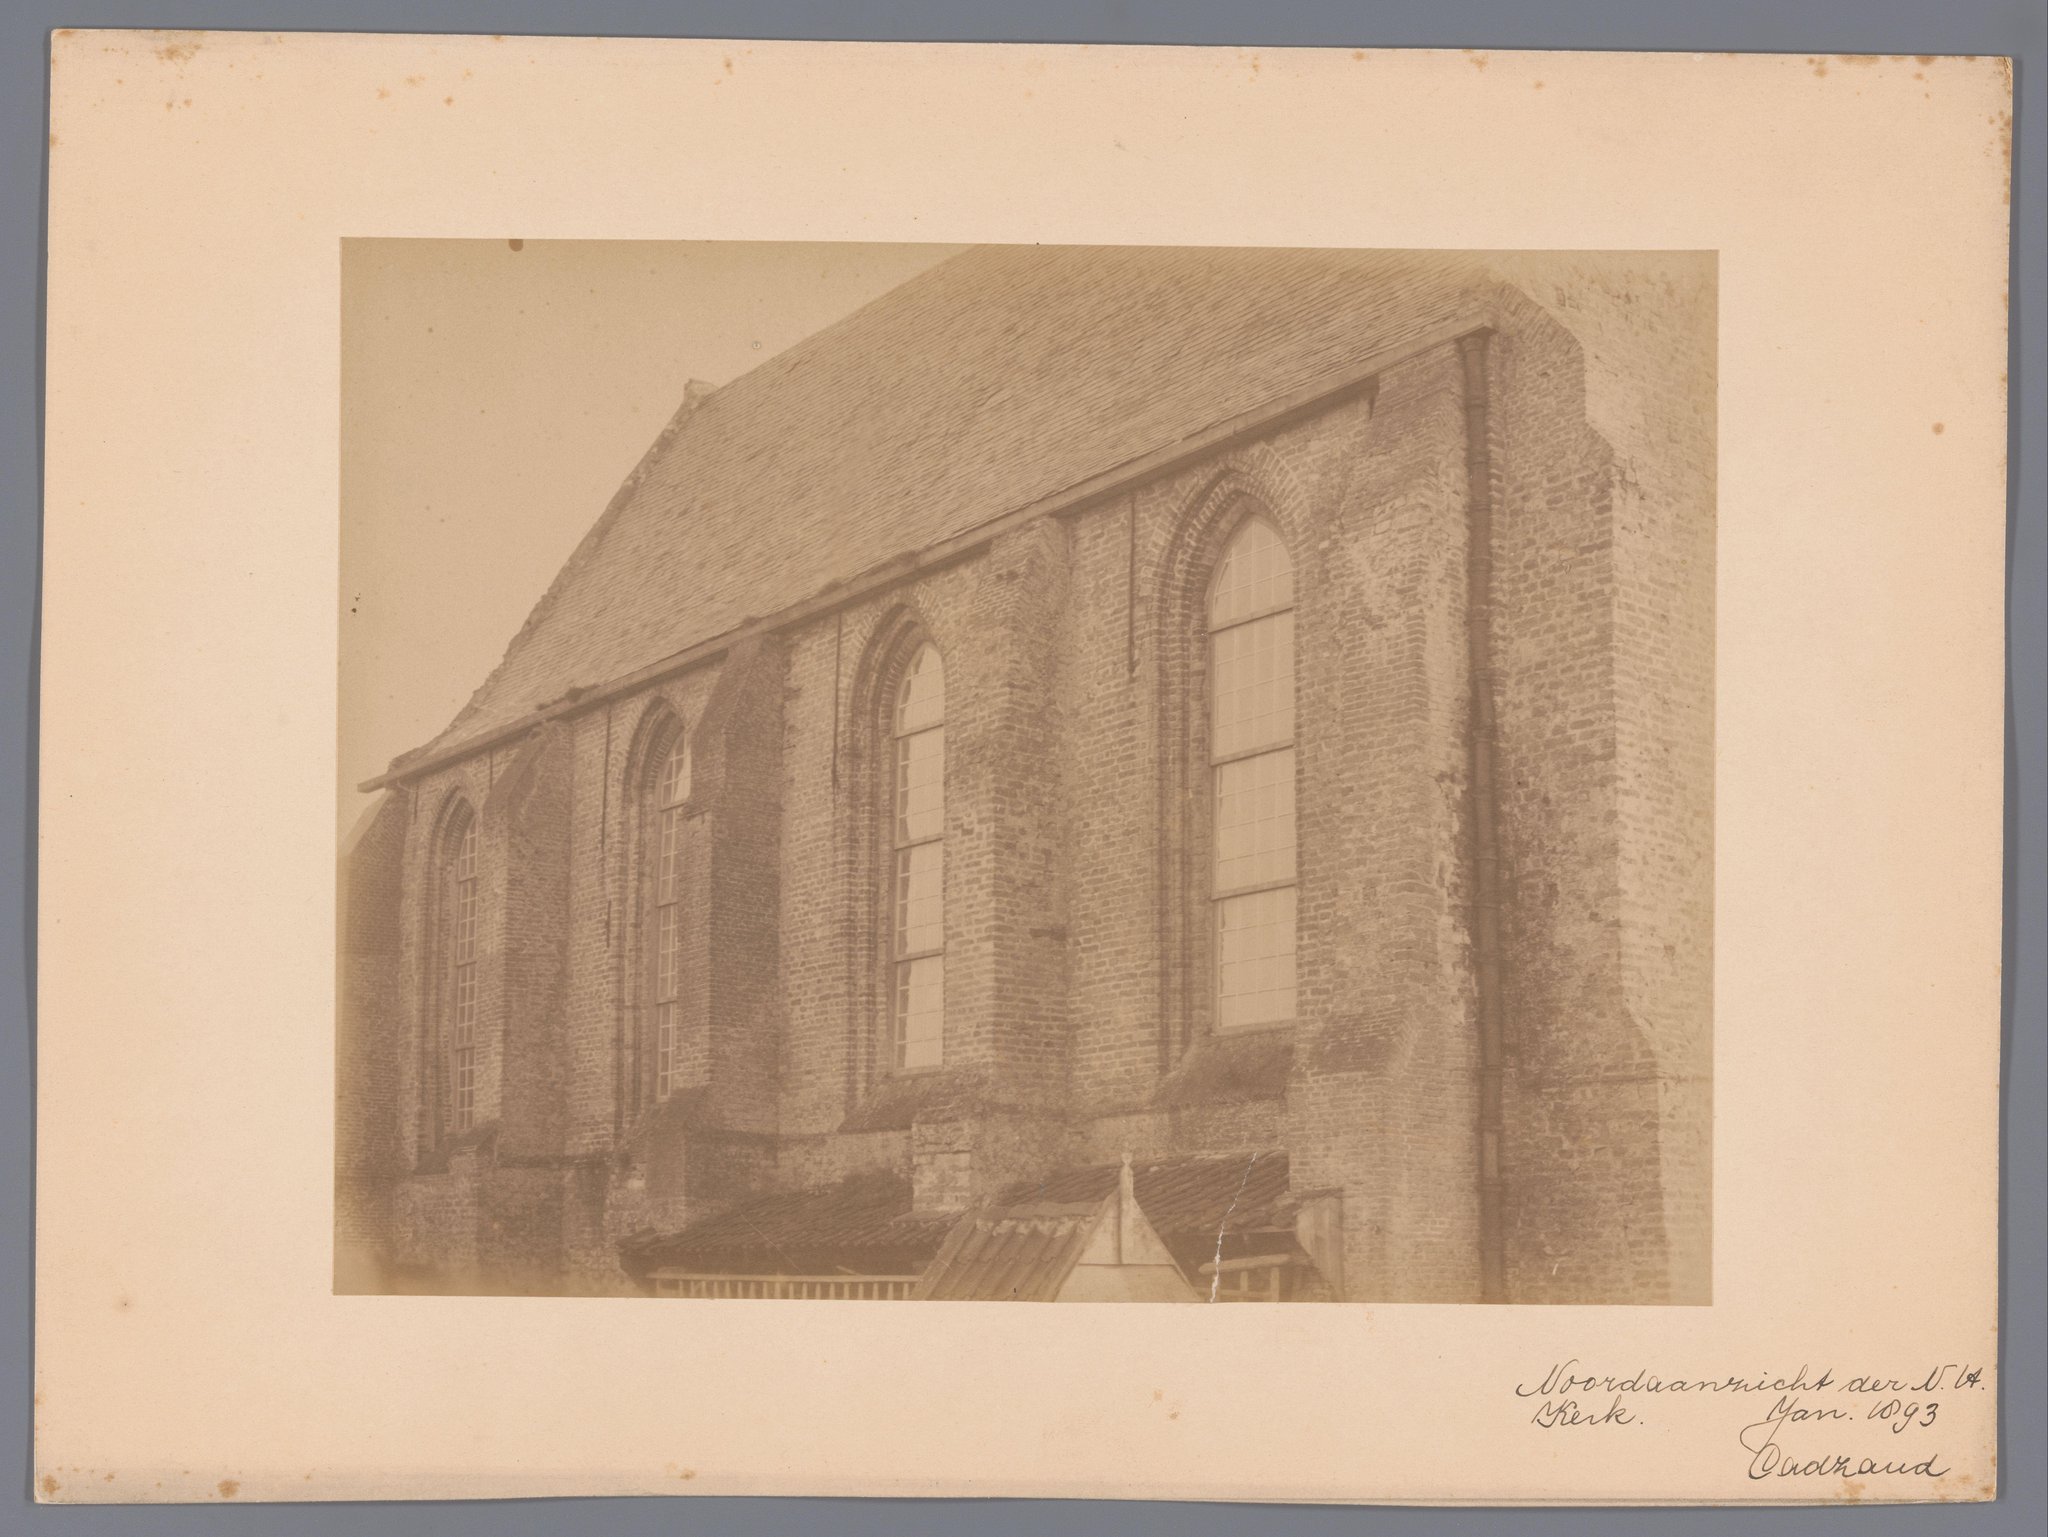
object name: photograph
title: Noordzijde van de Hervormde Kerk te Cadzand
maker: anoniem (monumentenzorg)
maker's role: fotograaf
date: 1893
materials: cardboard, photographic support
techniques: albumen print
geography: cadzand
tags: church (exterior)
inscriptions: annotation: ‘Kadzand/ Cadzand (Z)/ Noordaanzicht der N.H. Kerk/ Jan 93’, annotation: ‘Noordaanzicht der N.H. Kerk/ Jan. 1893/ Cadzand’